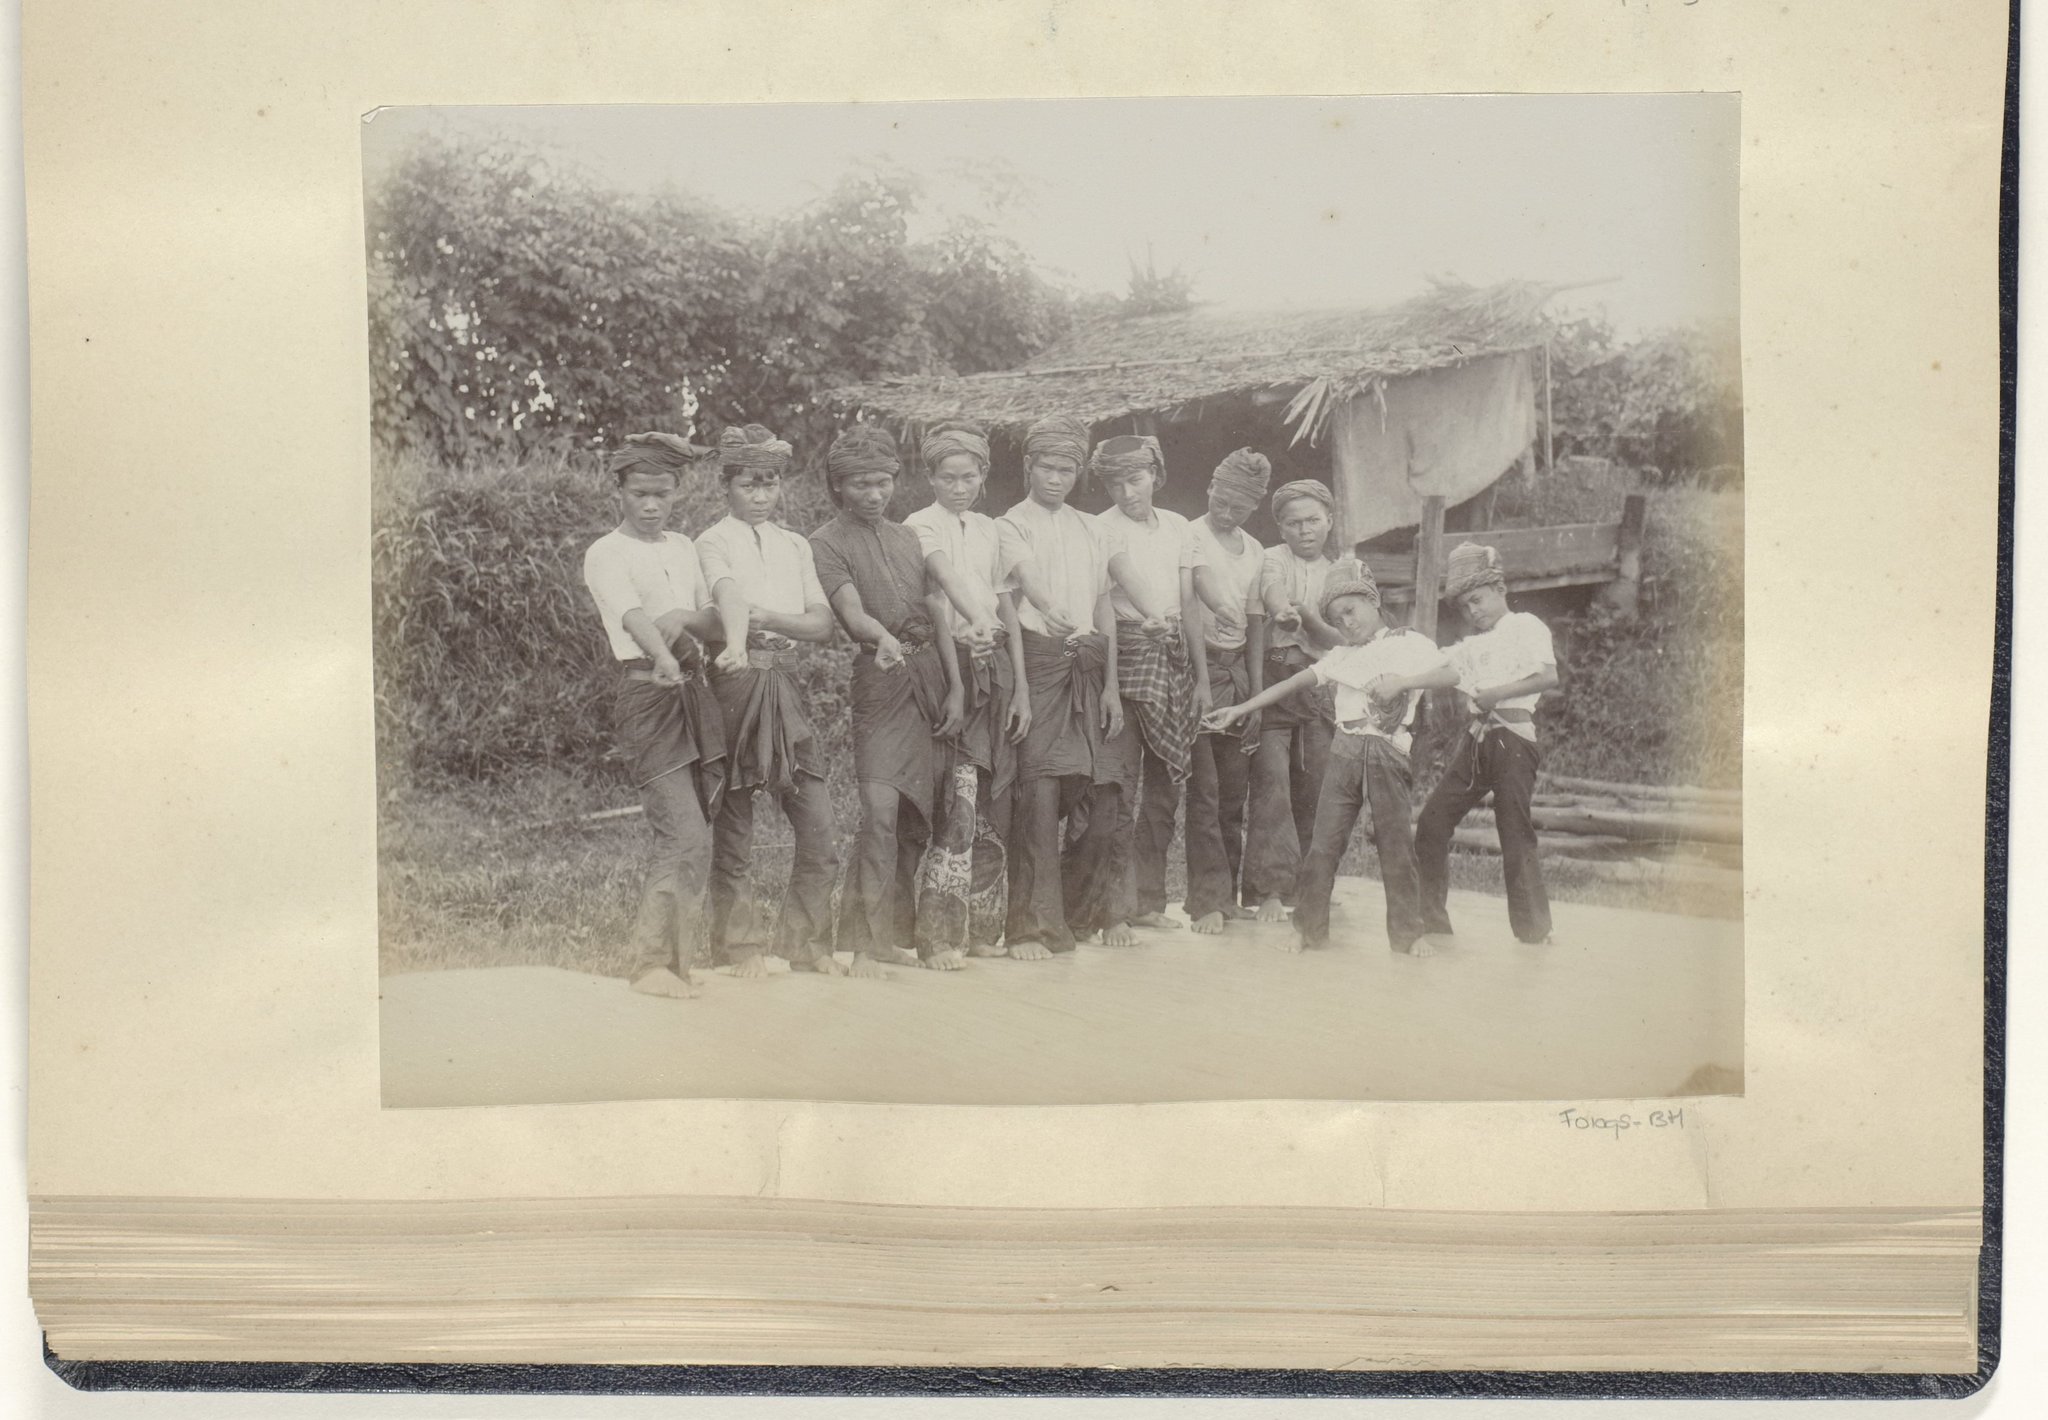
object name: photograph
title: Groep Indische jongens met de rechterarm vooruitgestoken, mogelijk dansers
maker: Anonymous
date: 1895-1905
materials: paper, photographic support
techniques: albumen print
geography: dutch east indies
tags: dancing, youth, adolescent, dutch east indies, the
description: Onderdeel van Reisalbum met foto's van bezienswaardigheden in Italië, Zwitserland en Nederlands-Indië.